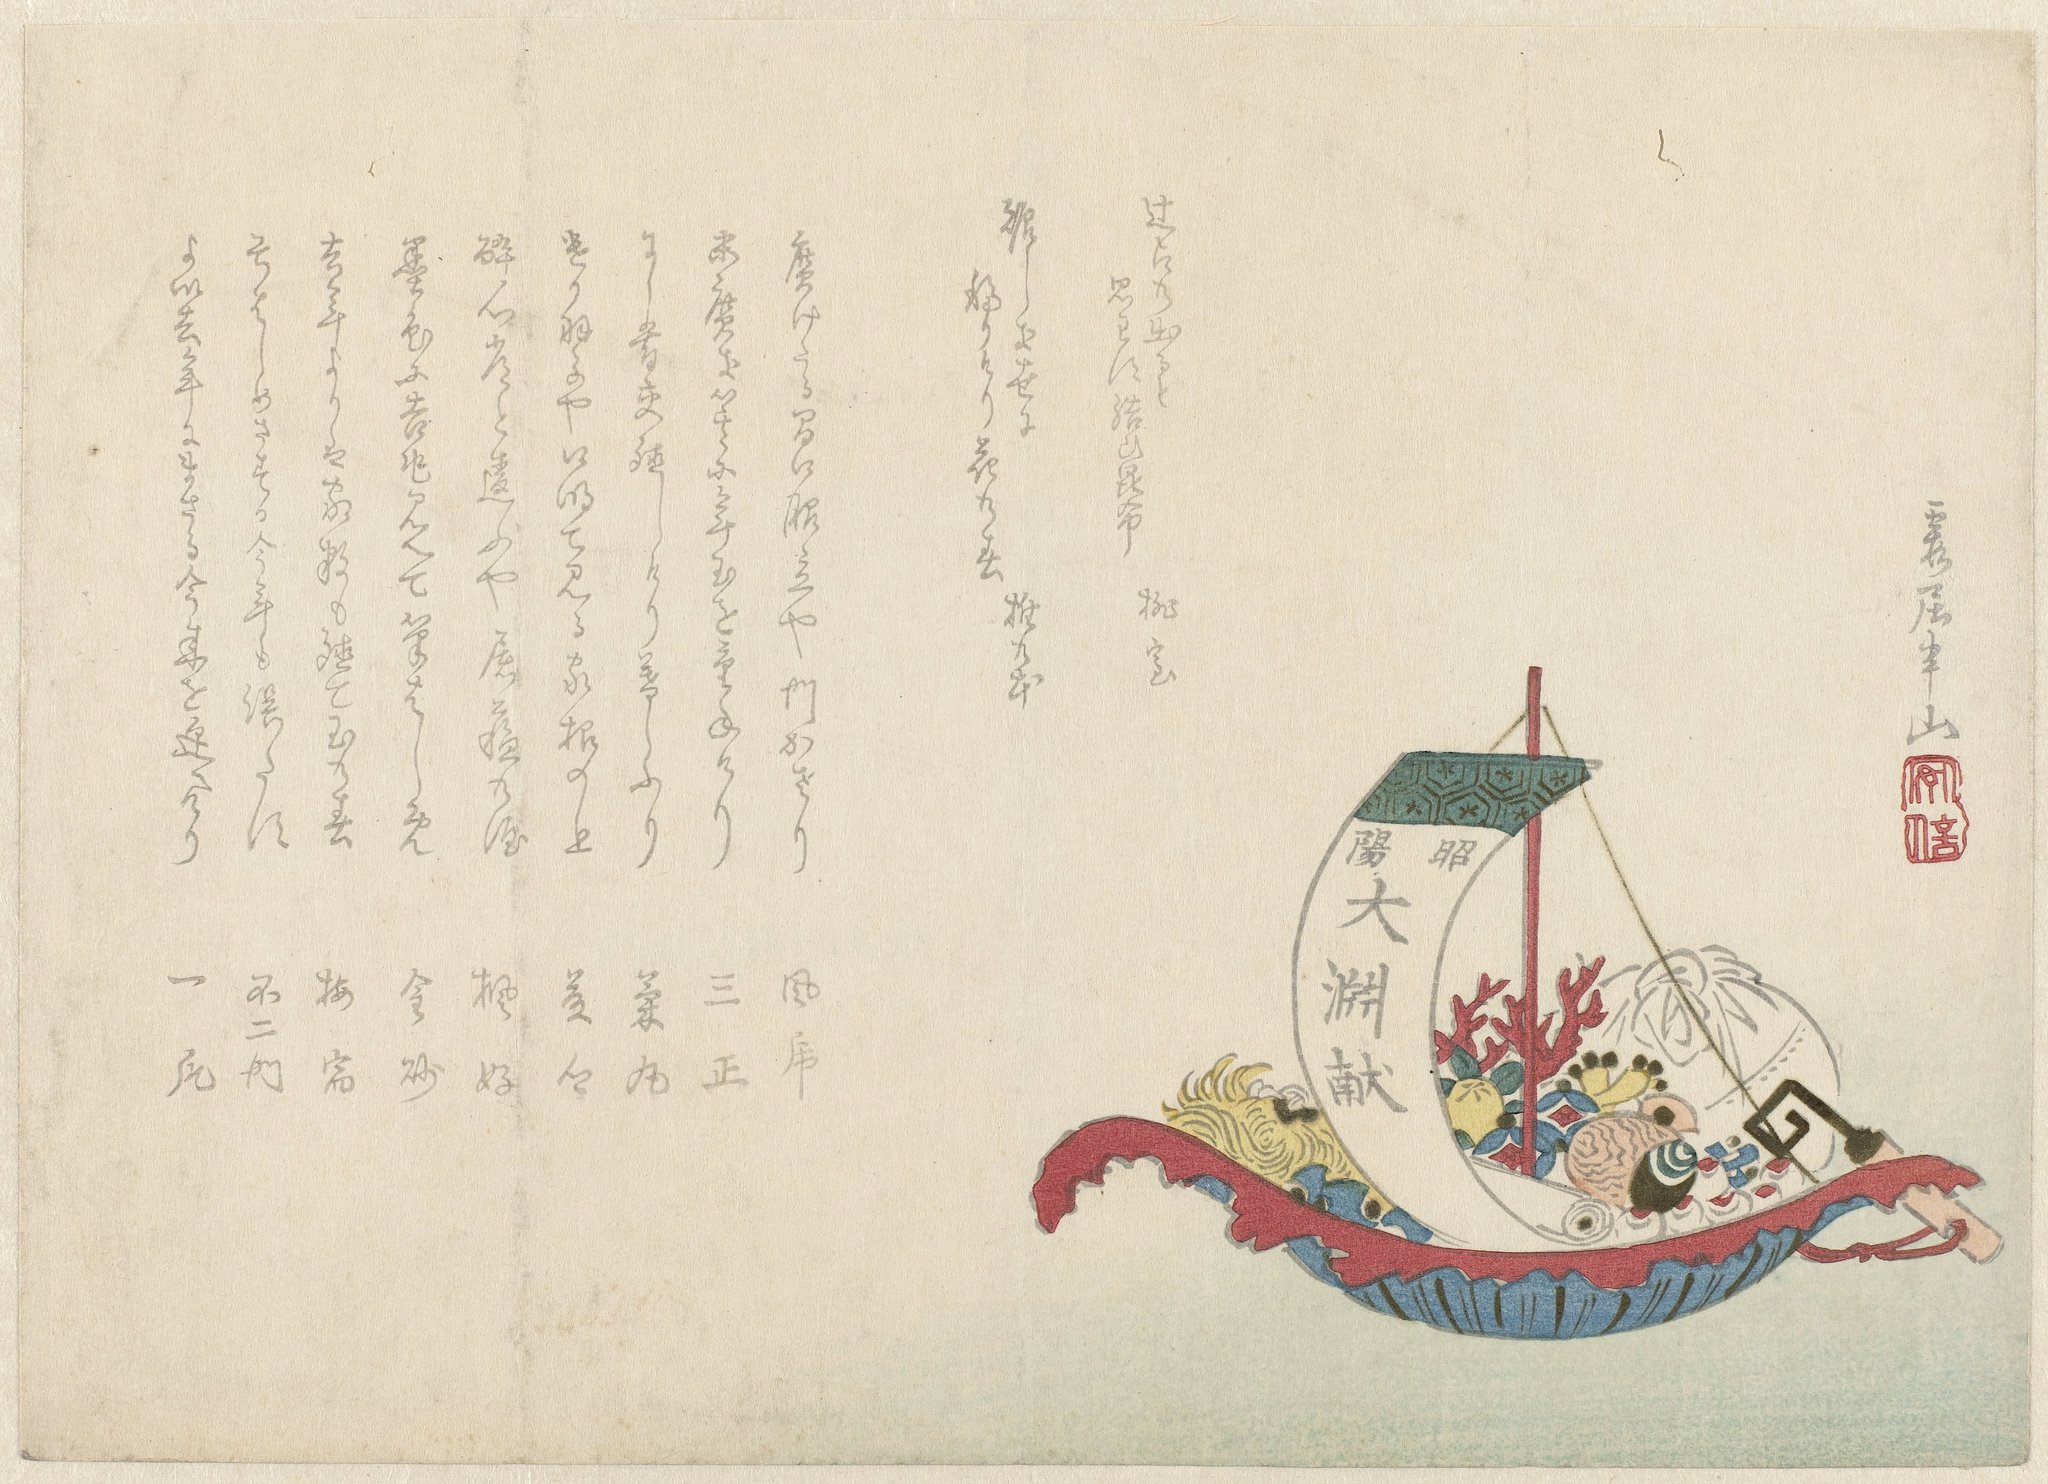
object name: print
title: Schip met giften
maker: matsukawa hanzan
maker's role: print maker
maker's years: 1805-1882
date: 1815-1882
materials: paper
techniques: woodcut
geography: japan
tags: ships (in general), cereal, grain, corn (grass with grains, grown for food, e.g.: wheat, rice, rye, oats, maize, buckwheat, millet)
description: Een surimono is een luxe uitgevoerde prent waarop beeld met één of meerdere gedichten gecombineerd is. Bij het drukken van een surimono werd vaak gebruik gemaakt van dikker papier, blinddruk en metaal pigmenten, zoals koper- en zilverpoeder. De prenten werden vaak in opdracht van dichters gemaakt en als exclusief geschenk aan vrienden en relaties gegeven.